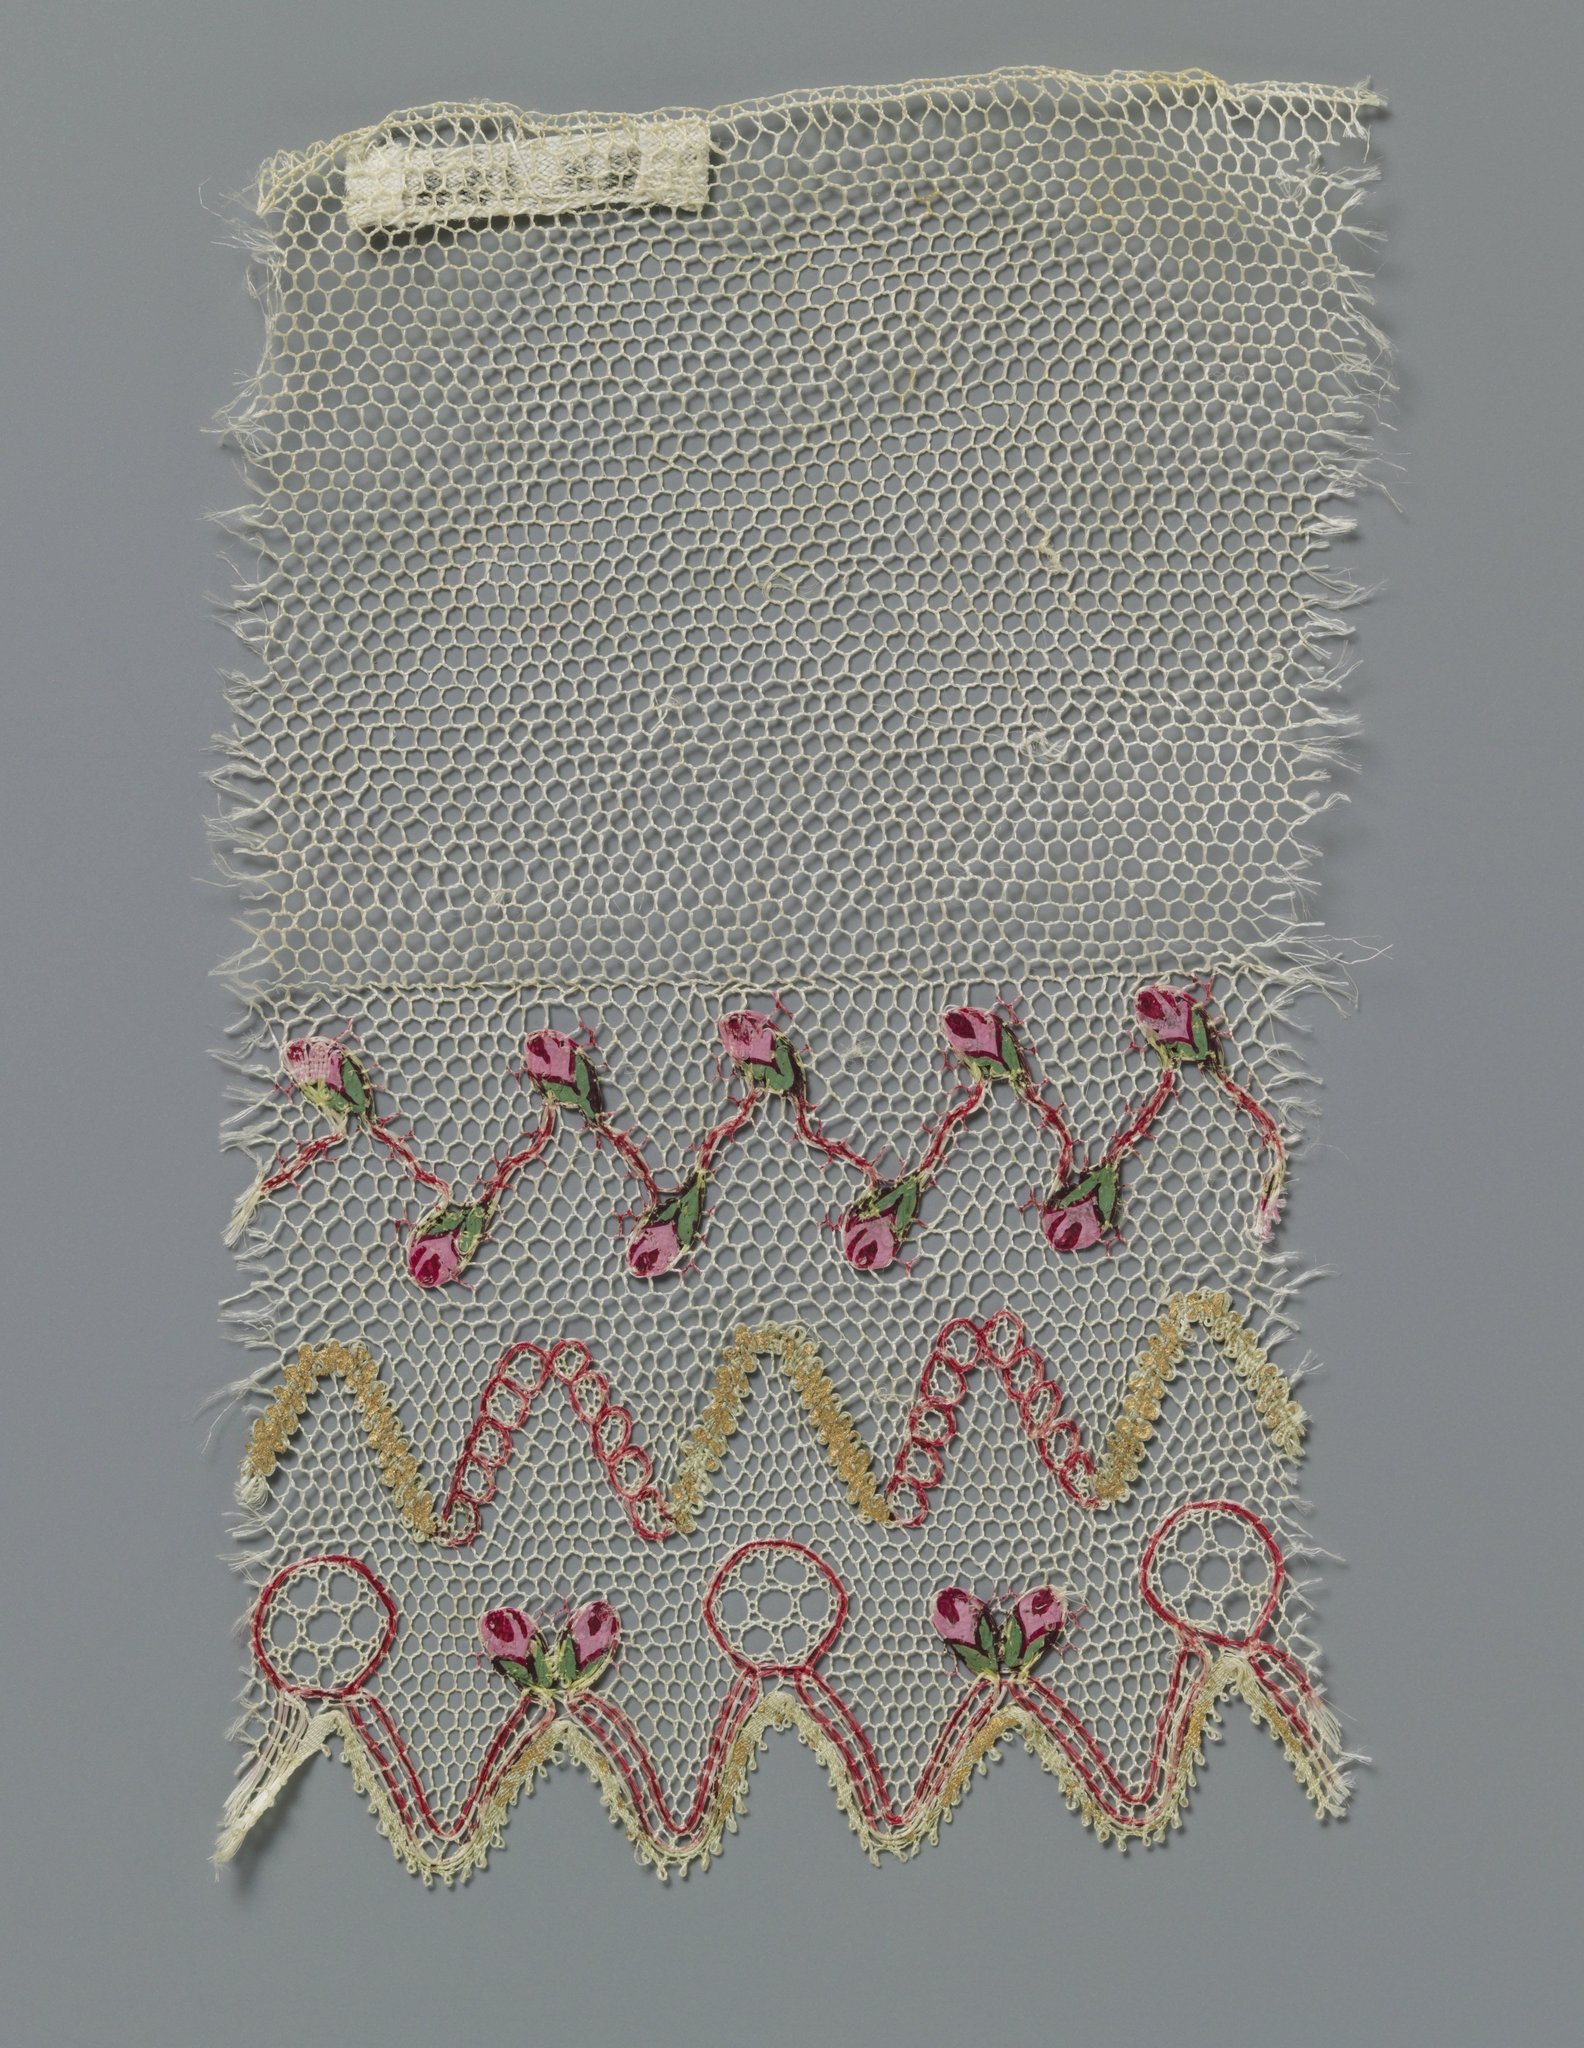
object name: strip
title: Strook kloskant met drie beschilderde zigzag-lijnen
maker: Anonymous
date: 1805-1815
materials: silk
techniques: lace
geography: france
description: Strook naturelkleurige kloskant, blonde, waarbij het patroon is beschilderd met goudkleur, rood, roze en groen. Het patroon begint op de onderste helft van de strook en bestaat uit drie boven elkaar geplaatste en verschillend vormgegeven zigzag-lijnen. De bovenste lijn bestaat uit rozenknopjes die met een zigzaglijn met elkaar zijn verbonden. De middelste lijn bestaat uit een zigzag-lijn van afwisselend een sterk in elkaar gedrukte kronkelende lijn en een lijn die is opgebouwd uit aan elkaar geschakelde cirkeltjes. De onderste lijn bestaat uit een zigzag-lijn die is opgebouwd met contourdraden met daaronder een smal bandje in linnenslag. Op de toppen van deze zigzag-lijn staat afwisselend een cirkel en een dubbele rozenknop. De rozenknopjes zijn gemaakt in linnenslag met contourdraden. De overige motieven zijn vrijwel uitsluitend met contourlijnen gemaakt en zijn met elkaar verbonden door een maasgrond, een tulegrond. Als siergrond is in zowel de kleine als de grote cirkels een rozengrond toegepast. De bovenzijde van de strook is recht afgewerkt. De onderste zigzag-lijn vormt tevens de puntige schulpenrand en deze is afgewerkt met picots.